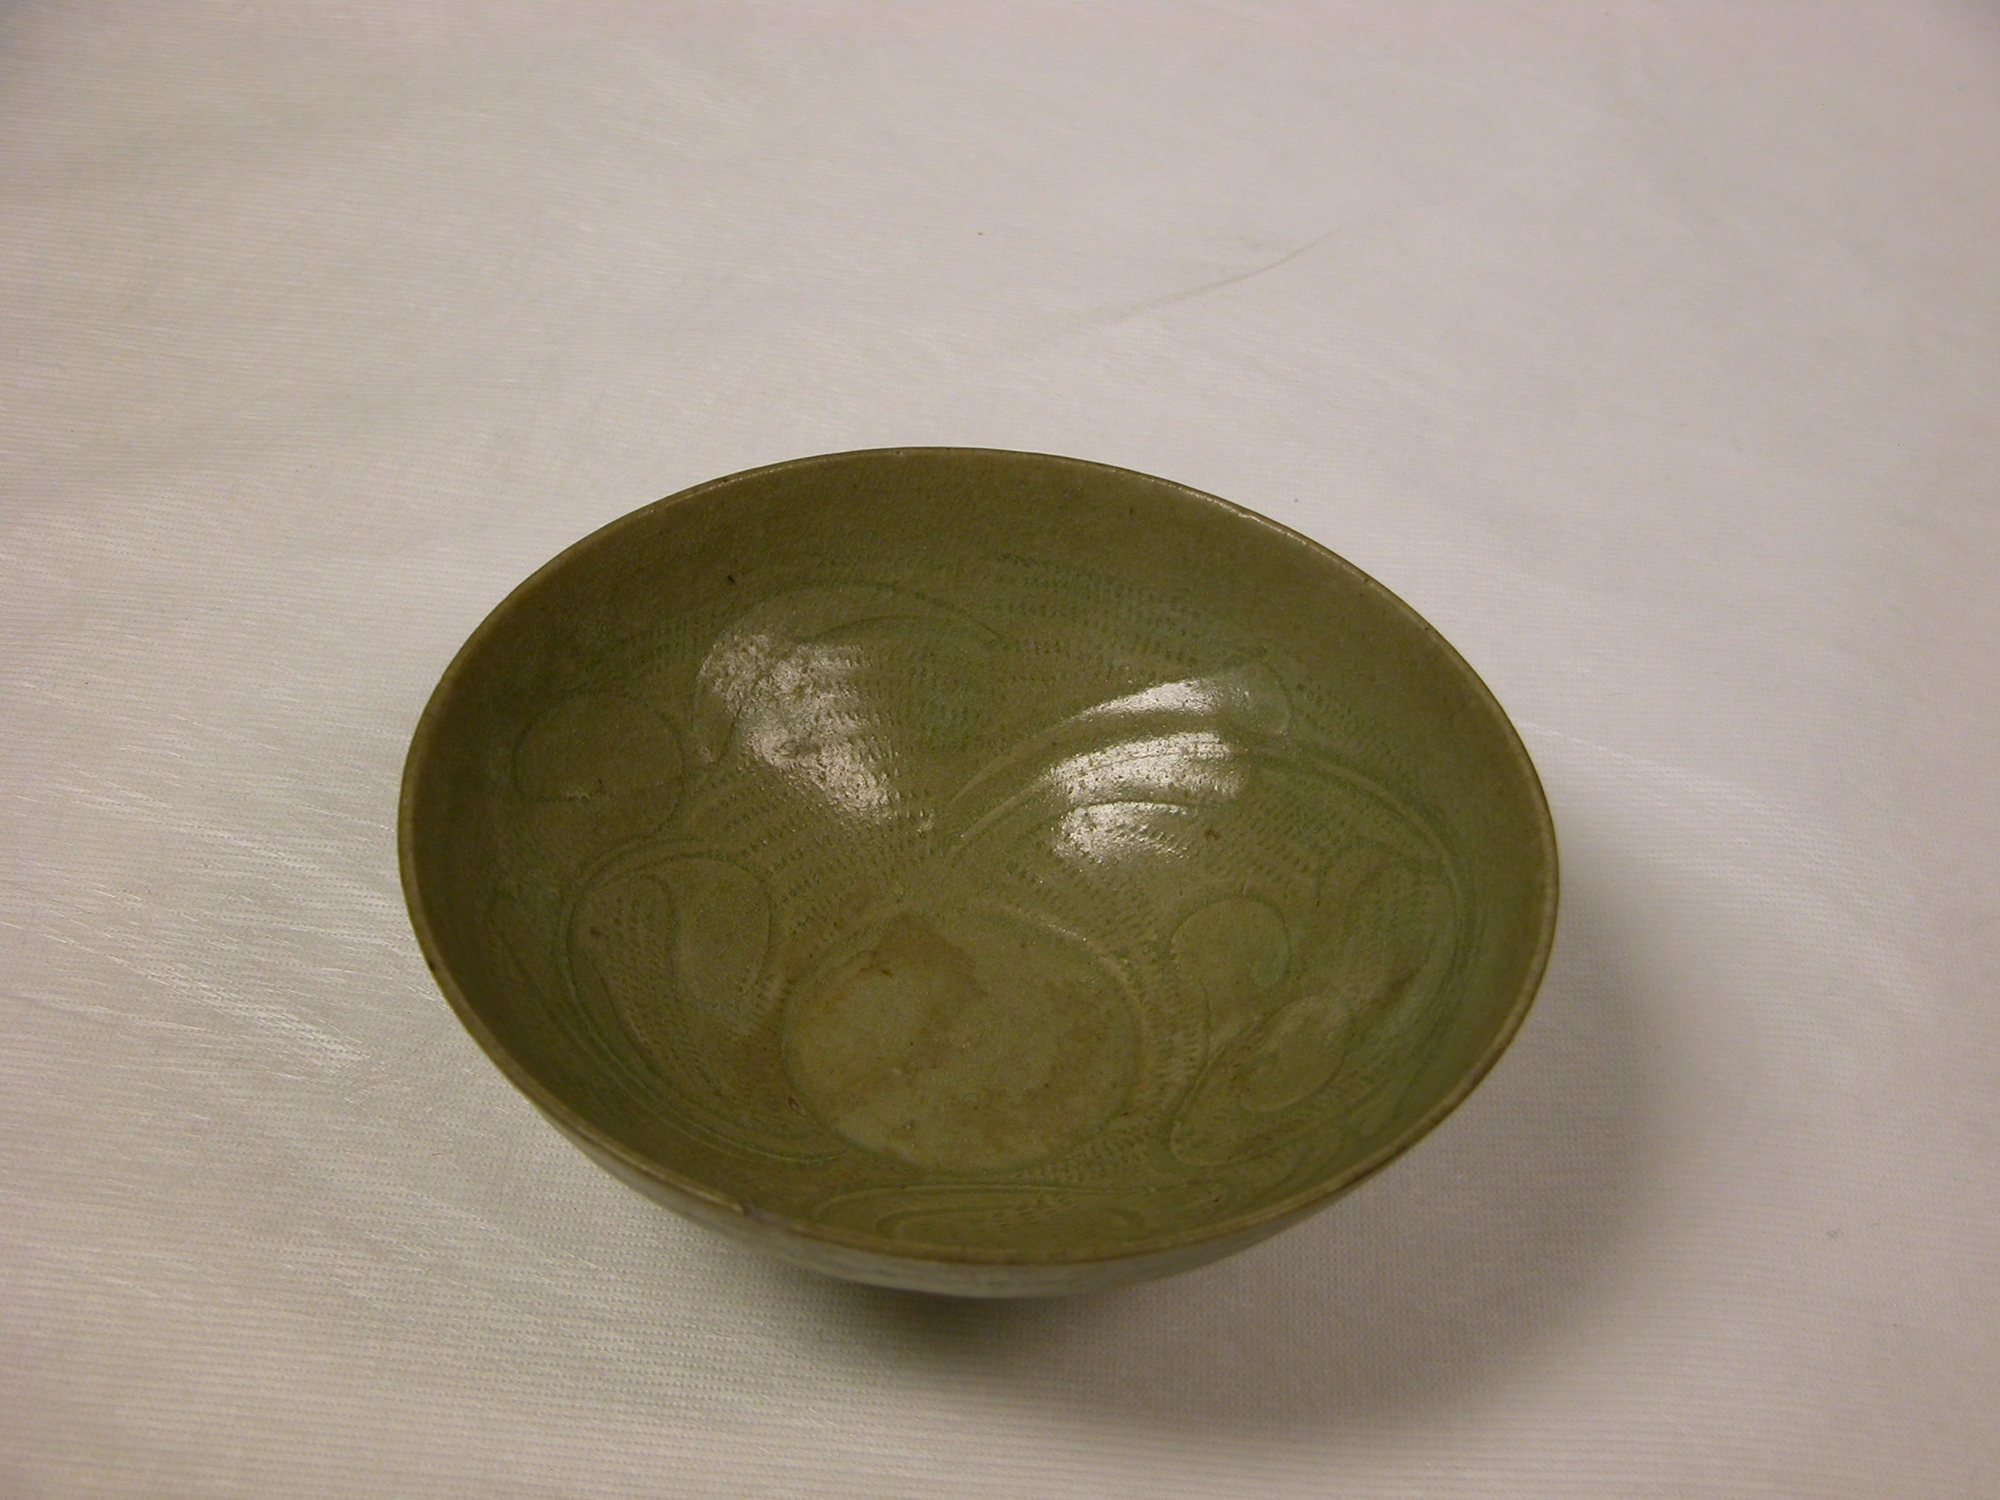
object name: bowl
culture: chinese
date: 960-1279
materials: pottery